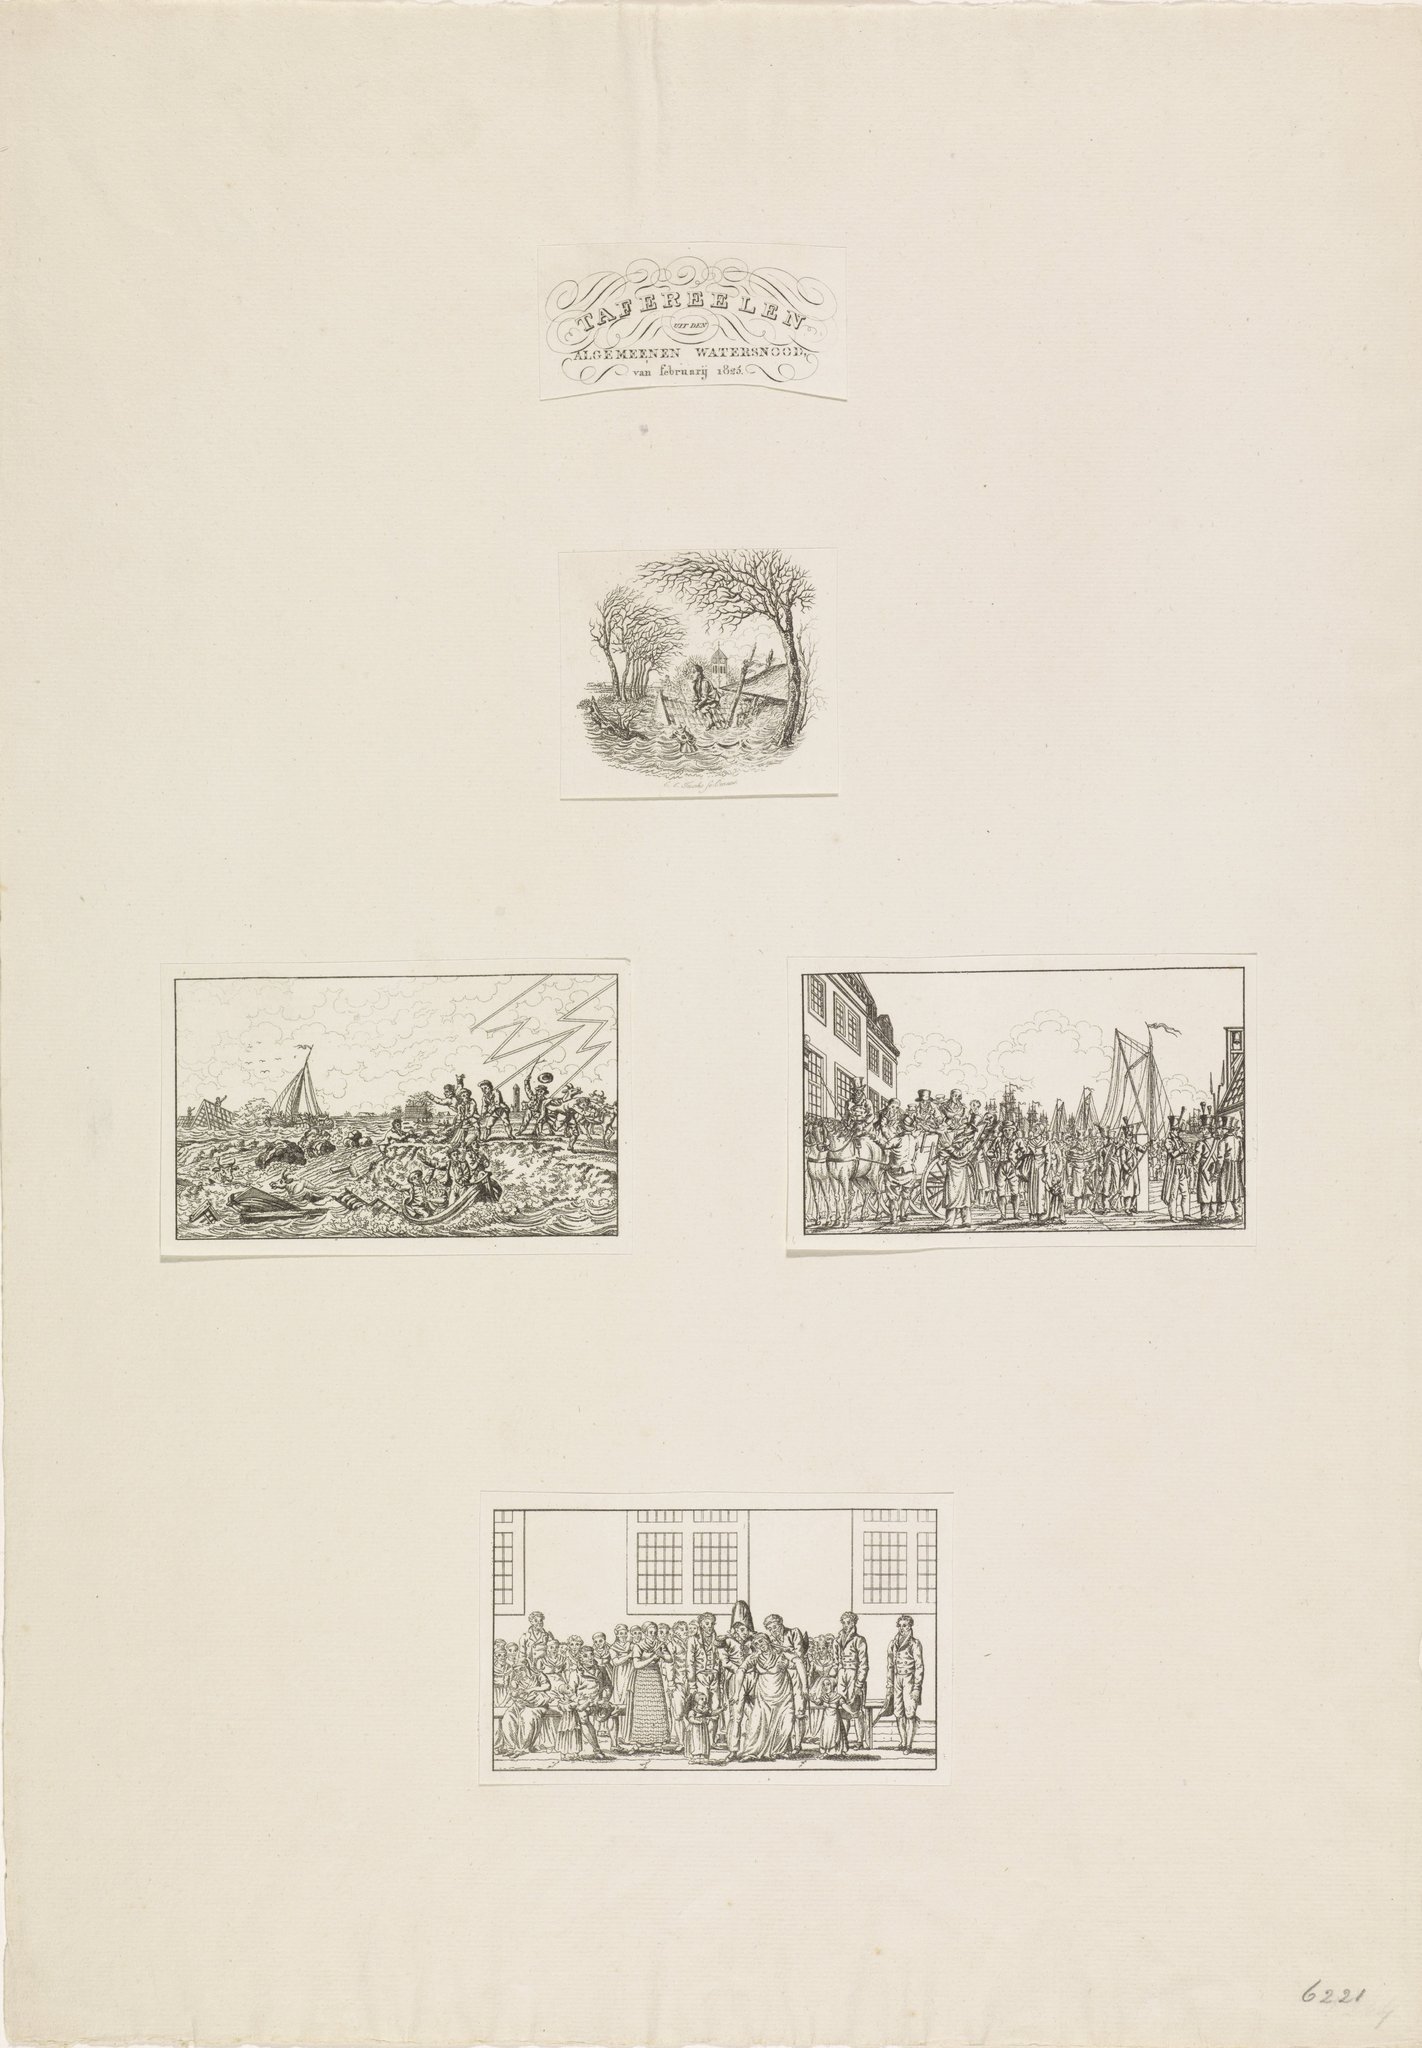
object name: print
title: Blad met vier taferelen van de watersnood van 1825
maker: karel christiaan fuchs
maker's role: draughtsman, print maker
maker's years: 1792-1855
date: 1825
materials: paper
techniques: etching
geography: netherlands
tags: the hague, william ii of the netherlands, flood, amsterdam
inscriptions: collector's mark: Lugt 2228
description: Blad met een titel en vier voorstellingen van de watersnood van februari 1825. Vijf kleine plaatjes uit een boek geknipt en opgeplakt op een groot vel papier. Bovenaan de titel, vervolgens de titelprent met een man zittend op het dak van zijn huis in het water, de dijkdoorbraak te Durgerdam, de aankomst van vluchtelingen uit Noord-Holland bij de Nieuwe Stadsherberg te Amsterdam en tenslotte het bezoek van de kroonprins aan de Aalmoezeniersweeshuis waar hij een onwel geworden zwangere vrouw in zijn armen houdt.